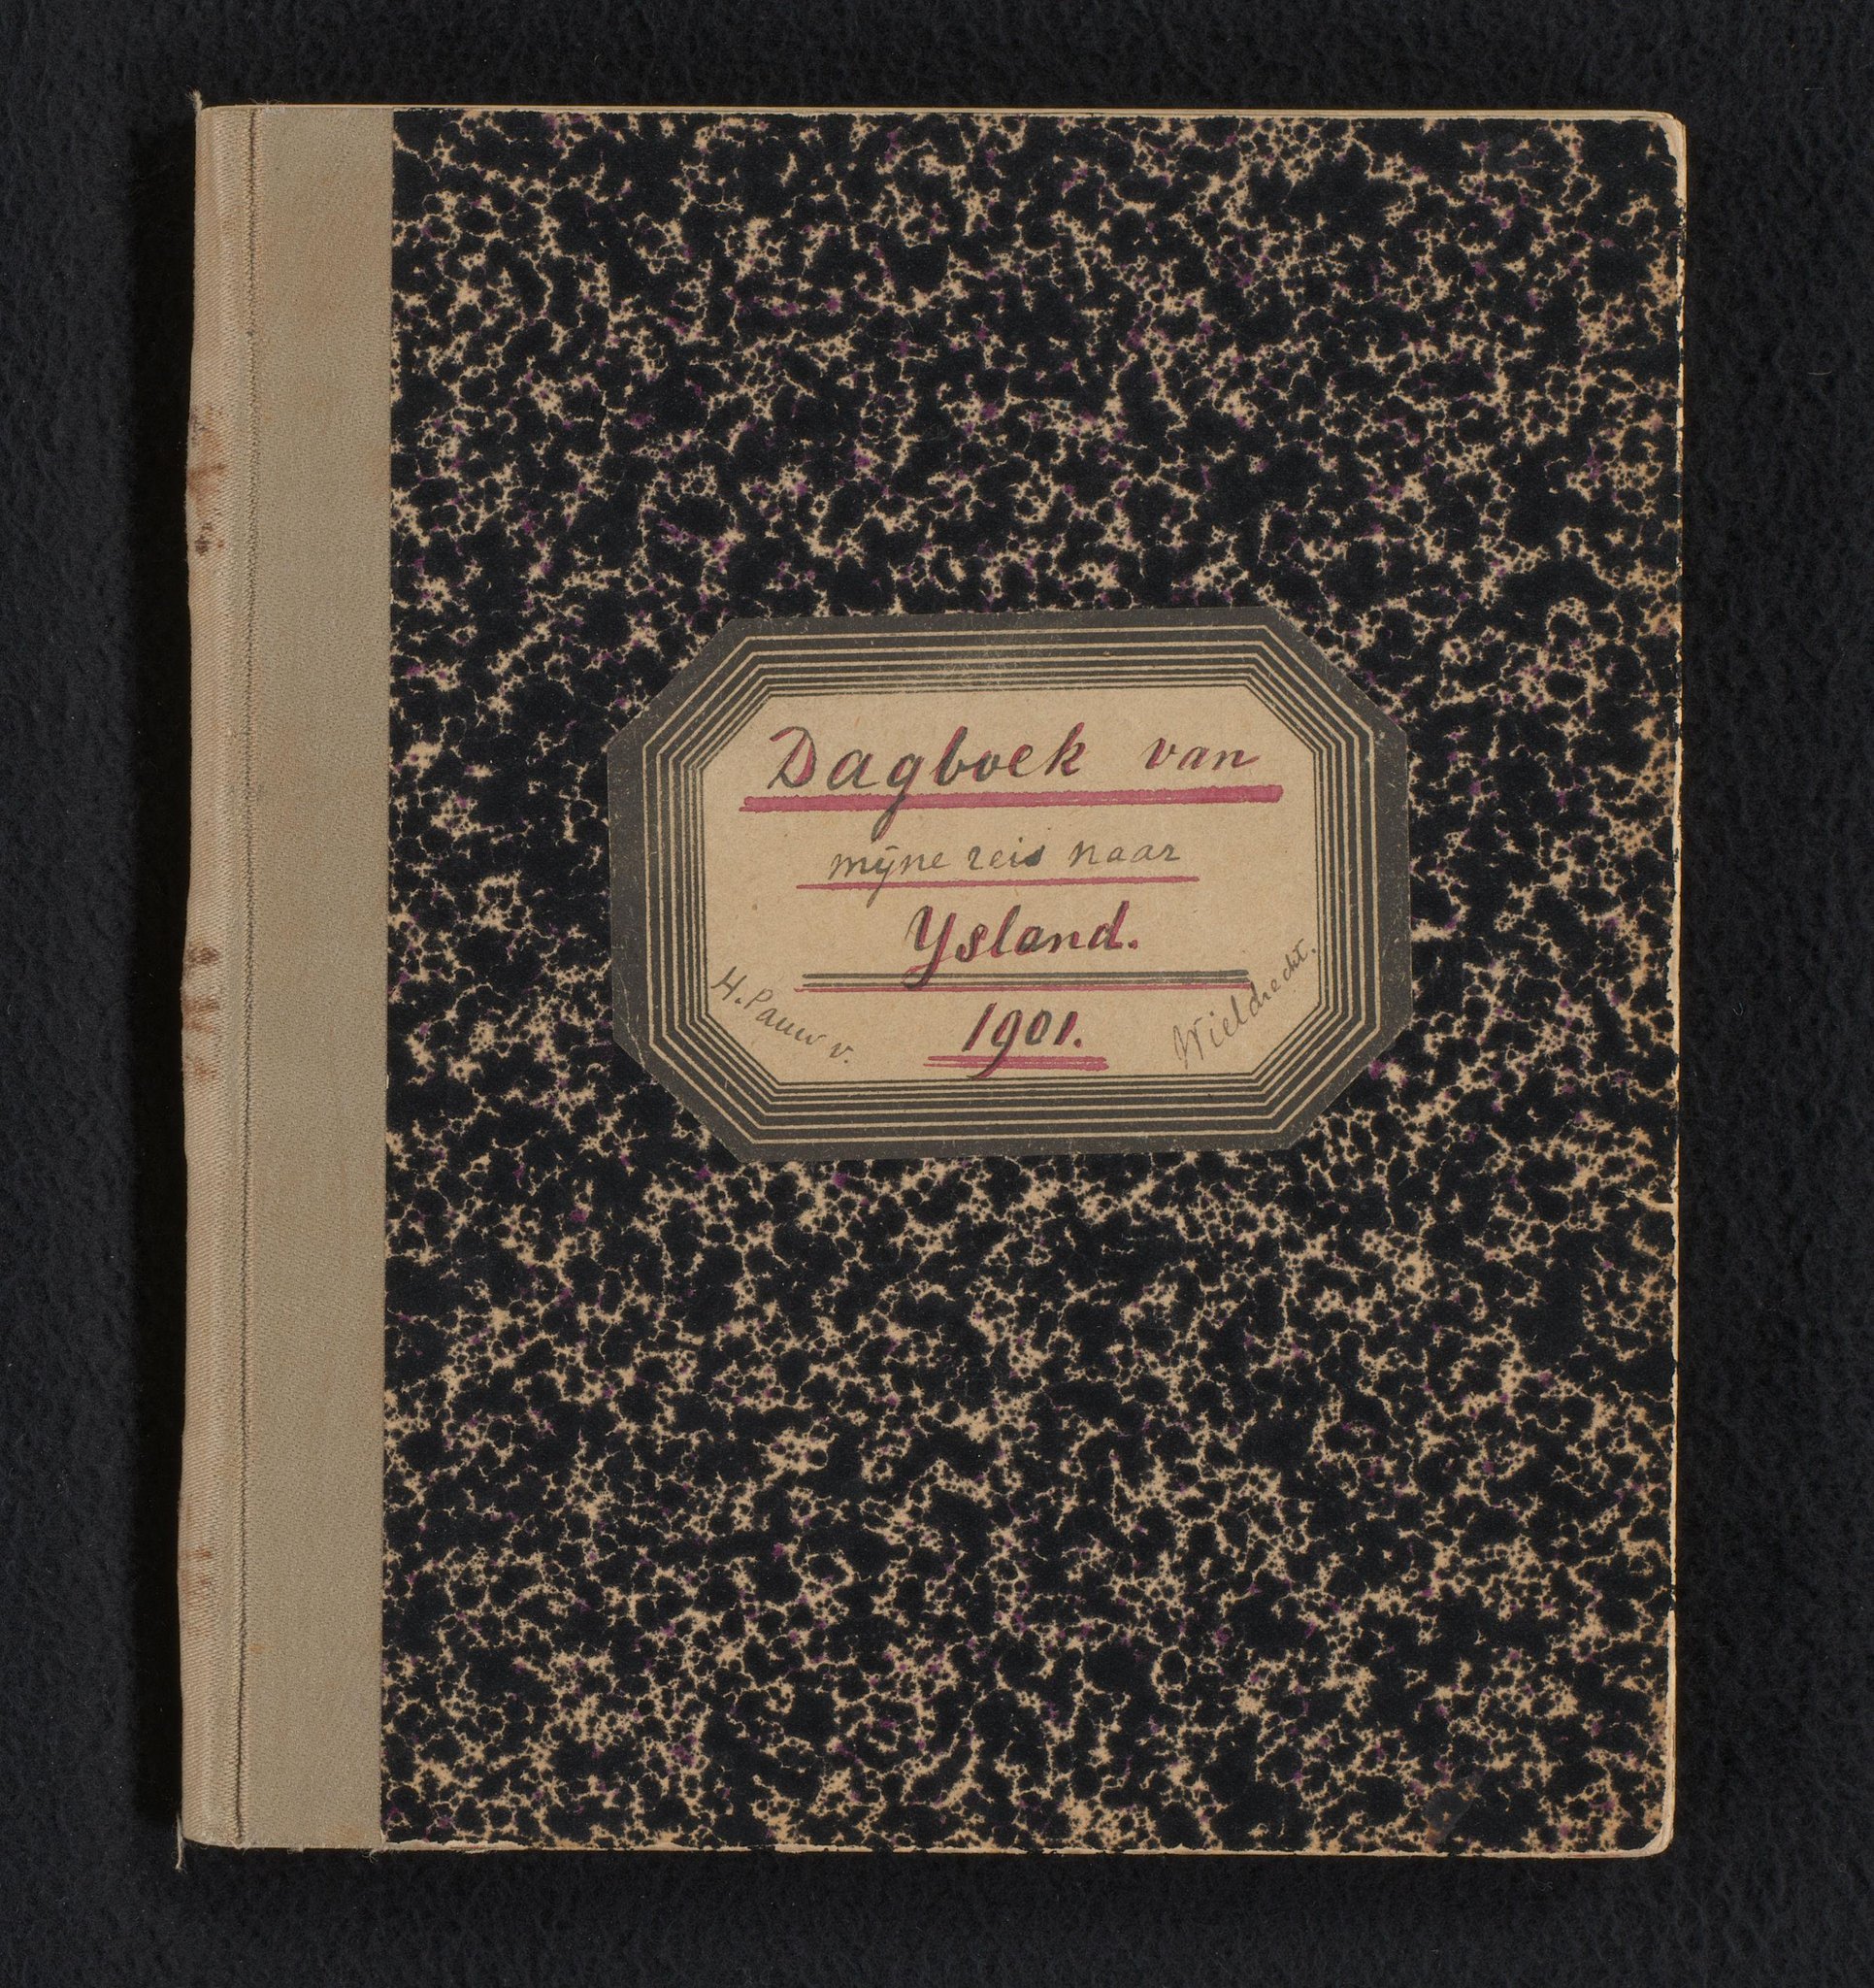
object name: reisverslag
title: Dagboek van mijne reis naar IJsland. 1901. H. Pauw v. Wieldrecht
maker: henry pauw van wieldrecht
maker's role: fotograaf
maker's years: 1863-1912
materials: cardboard, ink, paper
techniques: writing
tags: 'en route', traveller under way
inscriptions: number: ‘200-’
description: Reisverslag, opgetekend door Henry Pauw van Wieldrecht, van een reis naar IJsland. Pauw van Wieldrecht beschrijft wat hij dagelijks meemaakt. Het verslag omvat 97 beschreven bladzijden.